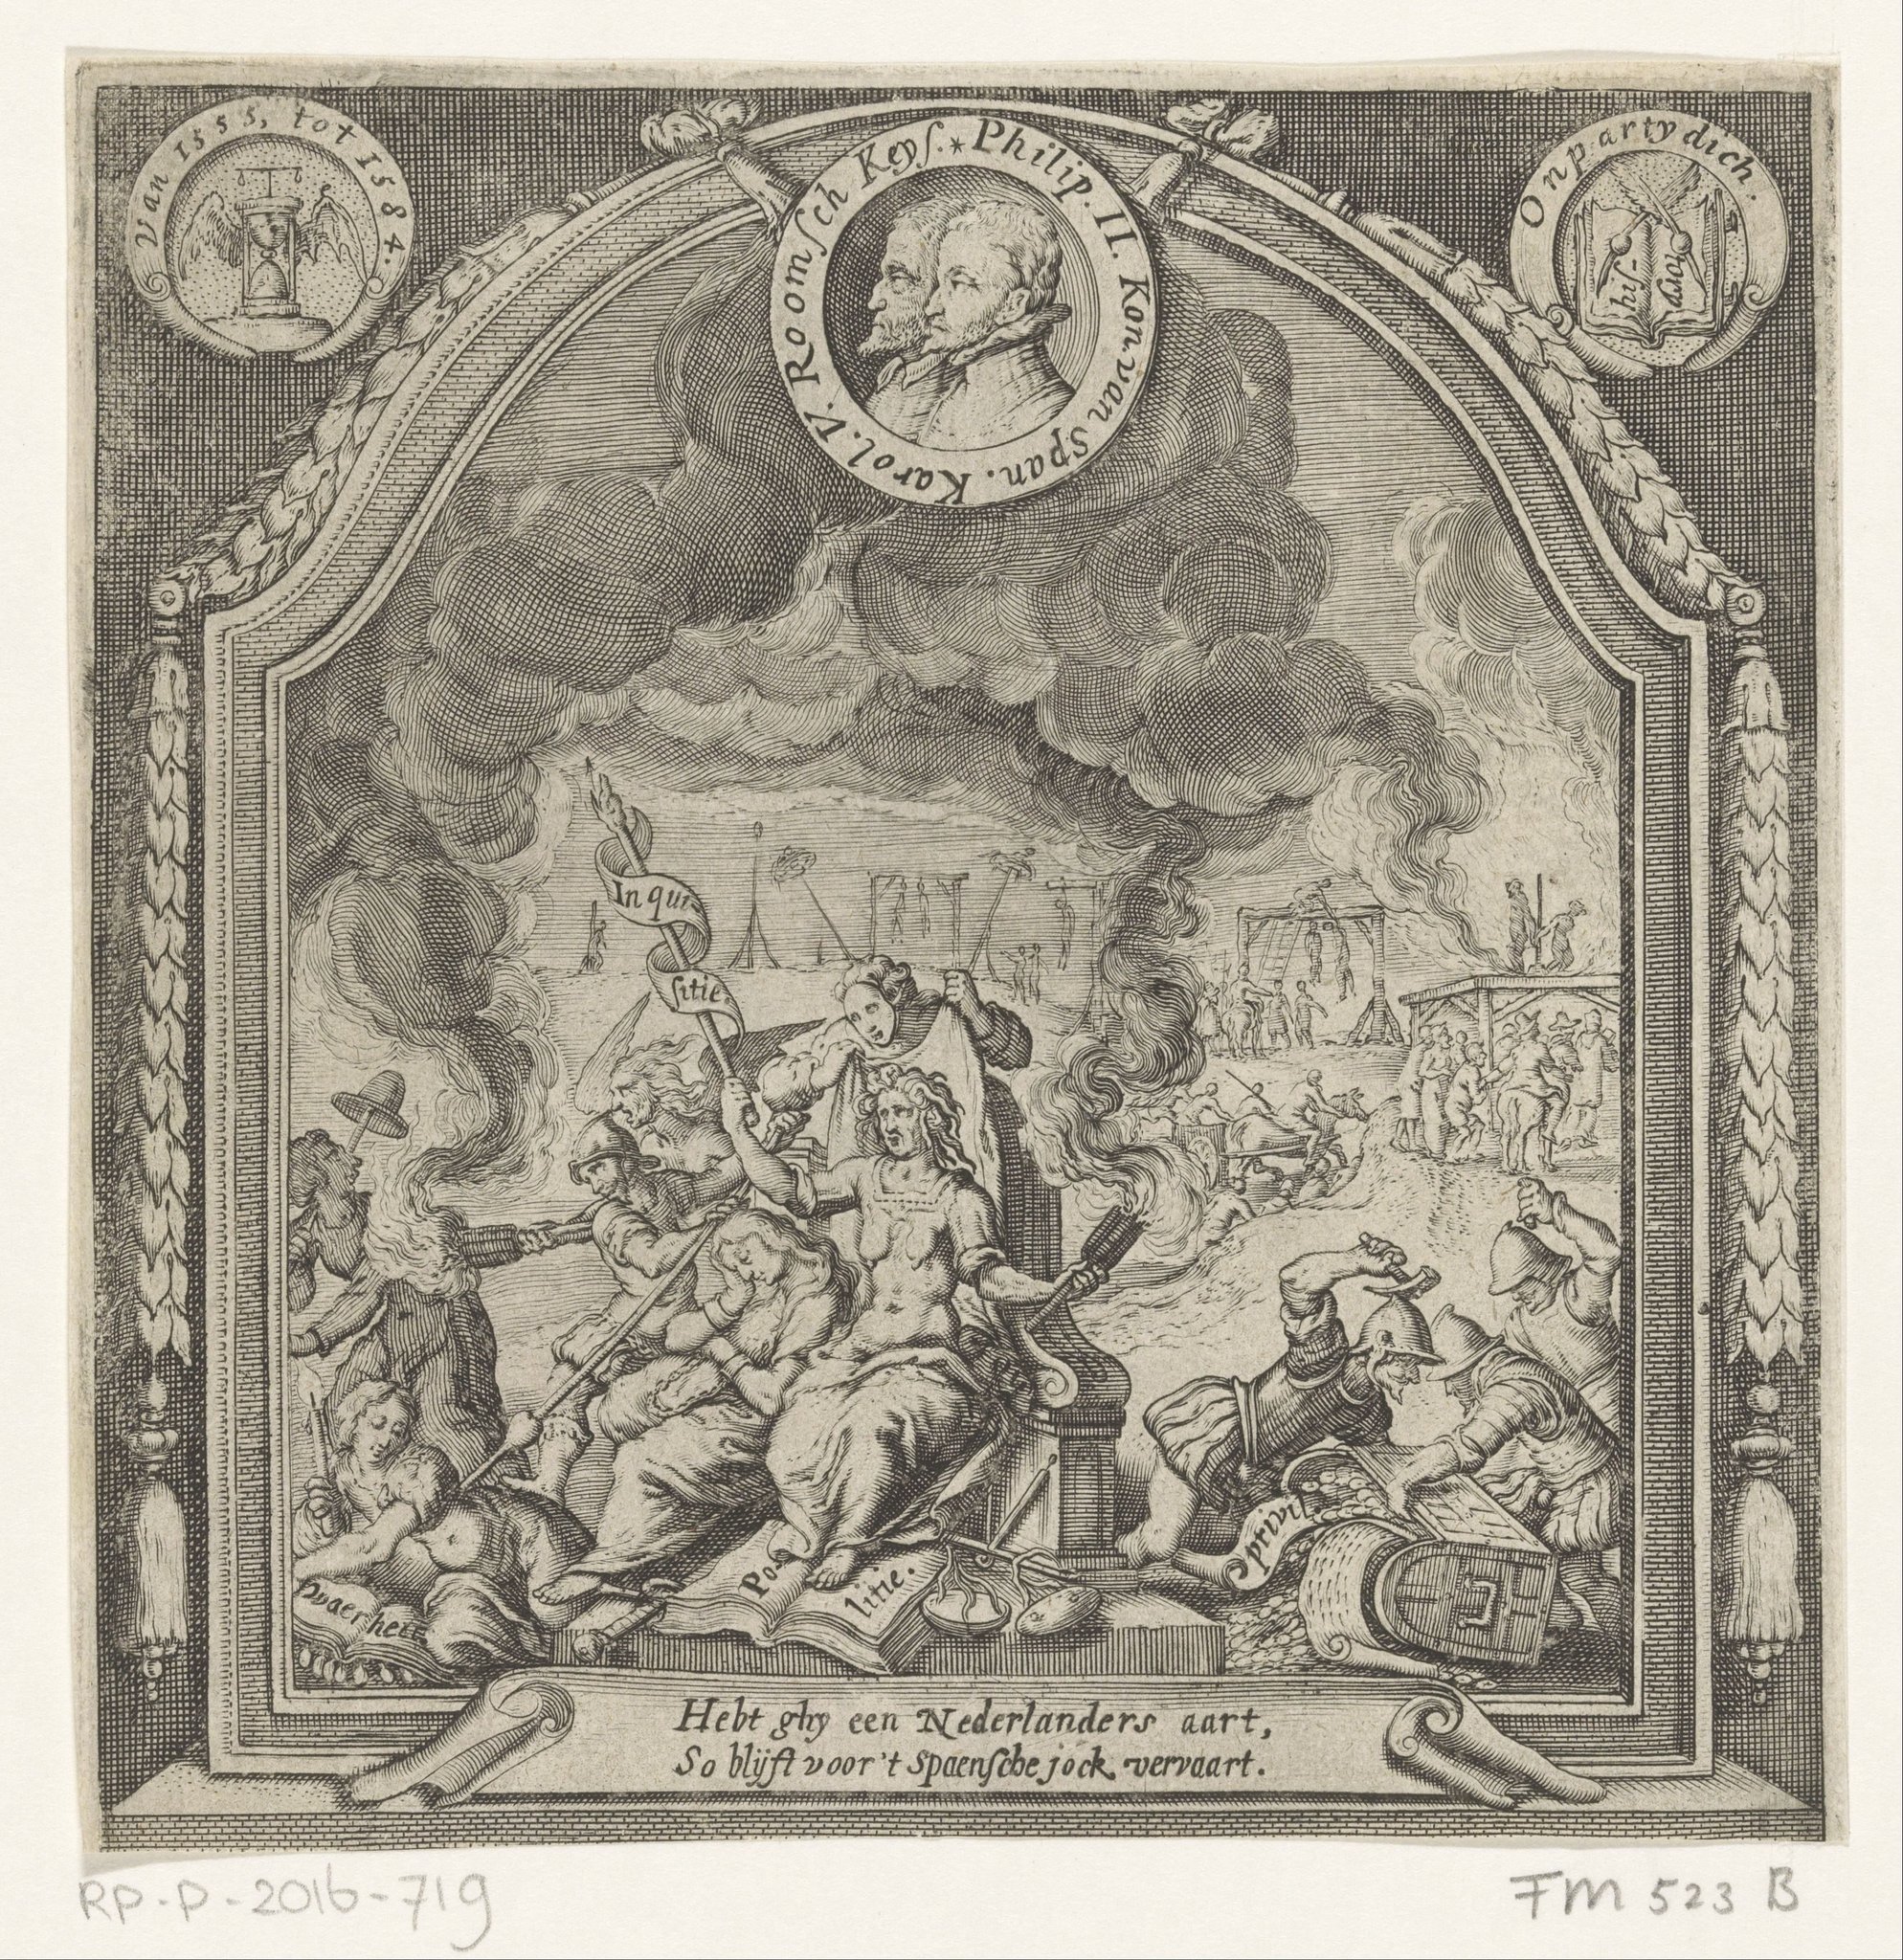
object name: titelblad, titelpagina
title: Allegorische voorstelling met Spaanse Inquisitie, Vrijheid en Waarheid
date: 1621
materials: paper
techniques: engraving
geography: amsterdam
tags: philip ii of spain, charles v (holy roman emperor and king of spain), violent death, being killed; being mishandled and maltreated; seeking death (+ death by inquisition), inquisition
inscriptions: collector's mark: Lugt 2228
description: De personificatie van de Spaanse Inquisitie met slangenhaar heeft de plaats ingenomen van Rechtvaardigheid die geboeid slaapt. Links wordt Vrijheid verjaagd en Waarheid doorstoken. Rechts plunderen Spaanse soldaten de geldkist met privileges. Op de achtergrond terechtstellingen. Bovenaan in medaillon de portretten van Filips II en Karel V. Onderaan een motto van 2 regels in het Nederlands. Onderste deel van de prent gesneden.